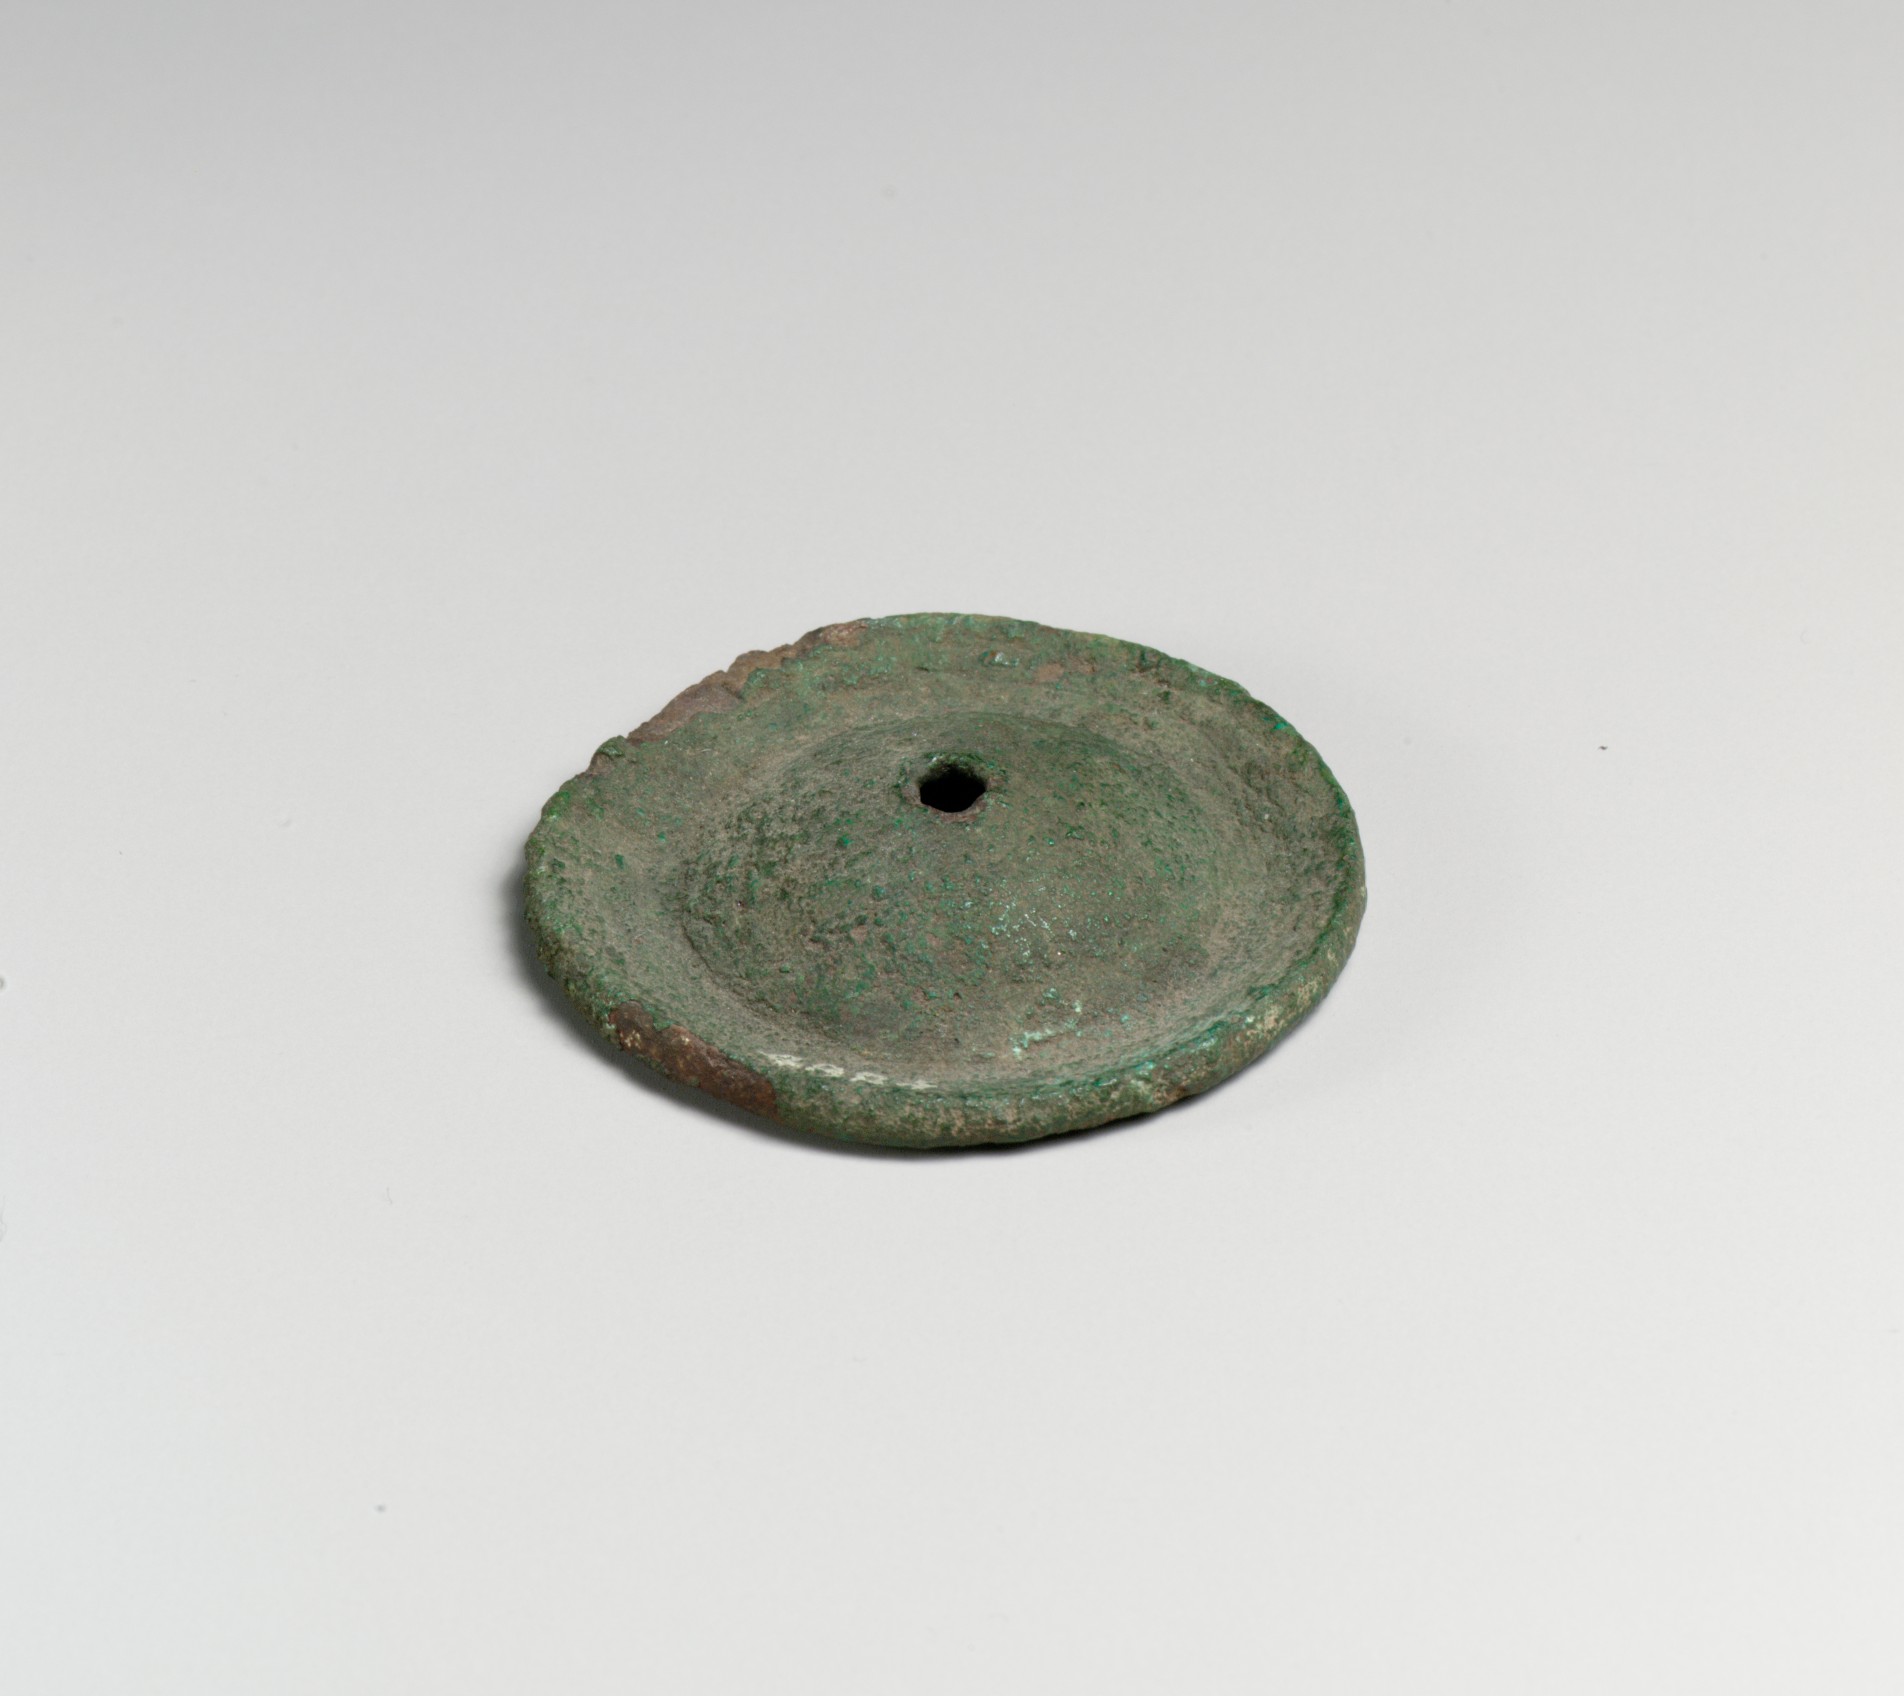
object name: cymbal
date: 7000 BCE-330 CE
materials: bronze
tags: musical instruments